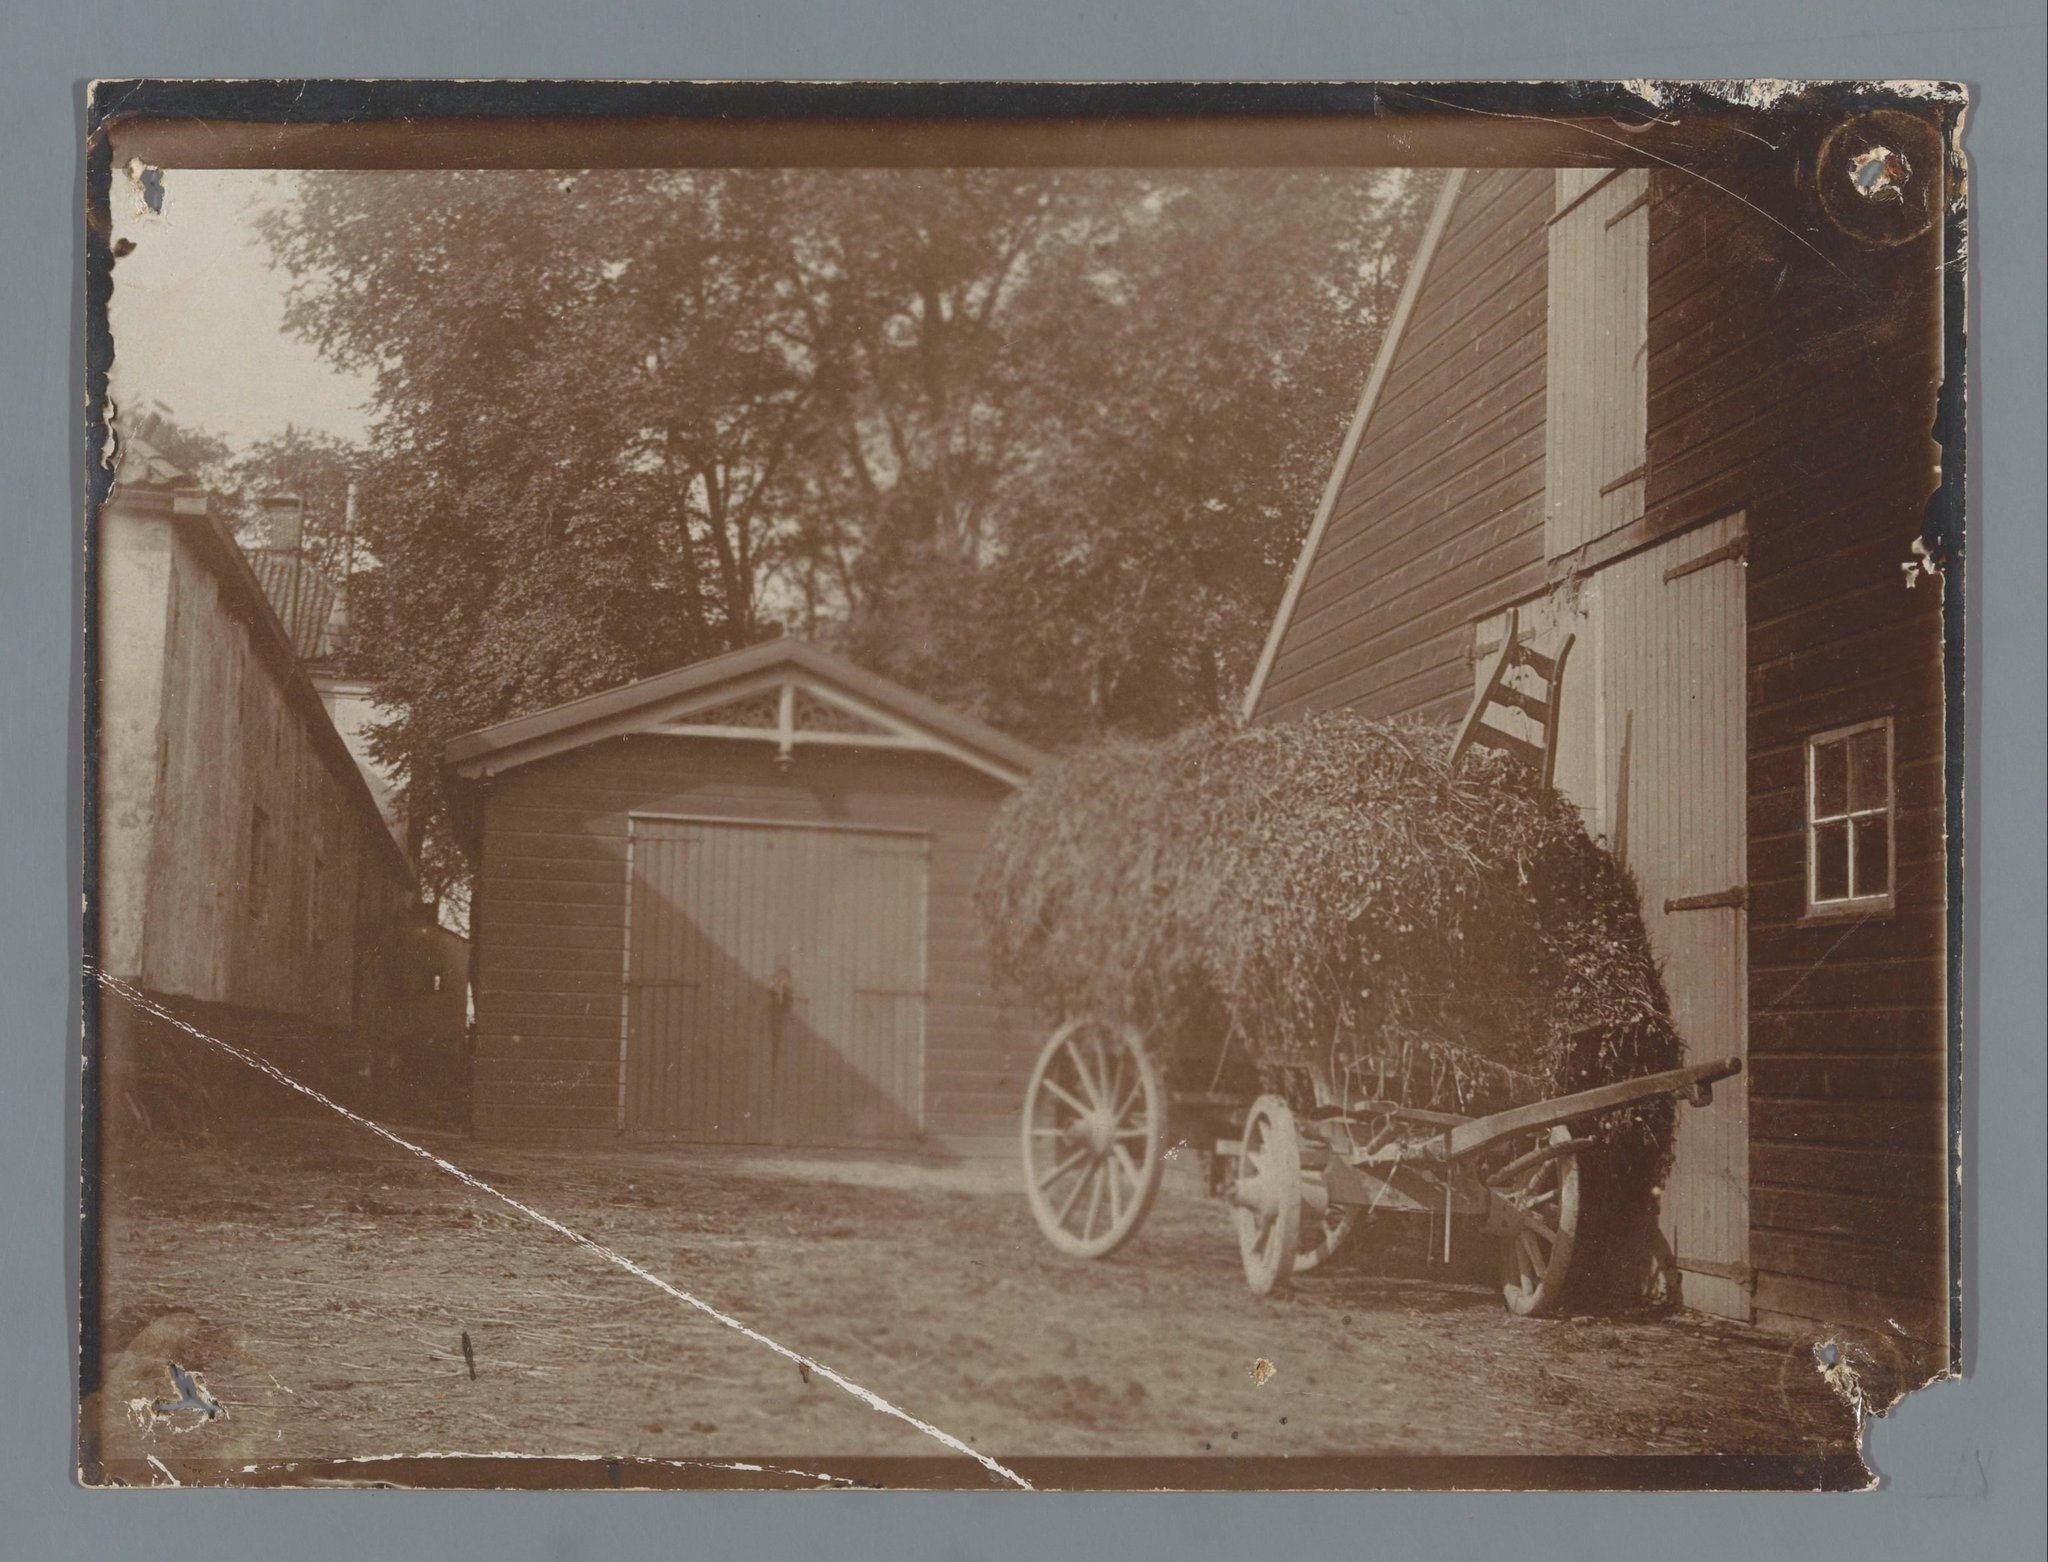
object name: photograph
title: Hooiwagen op het erf van een boerderij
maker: Anonymous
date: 1895-1910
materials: photographic support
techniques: daylight paper print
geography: netherlands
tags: hay-wagon, farm (building)